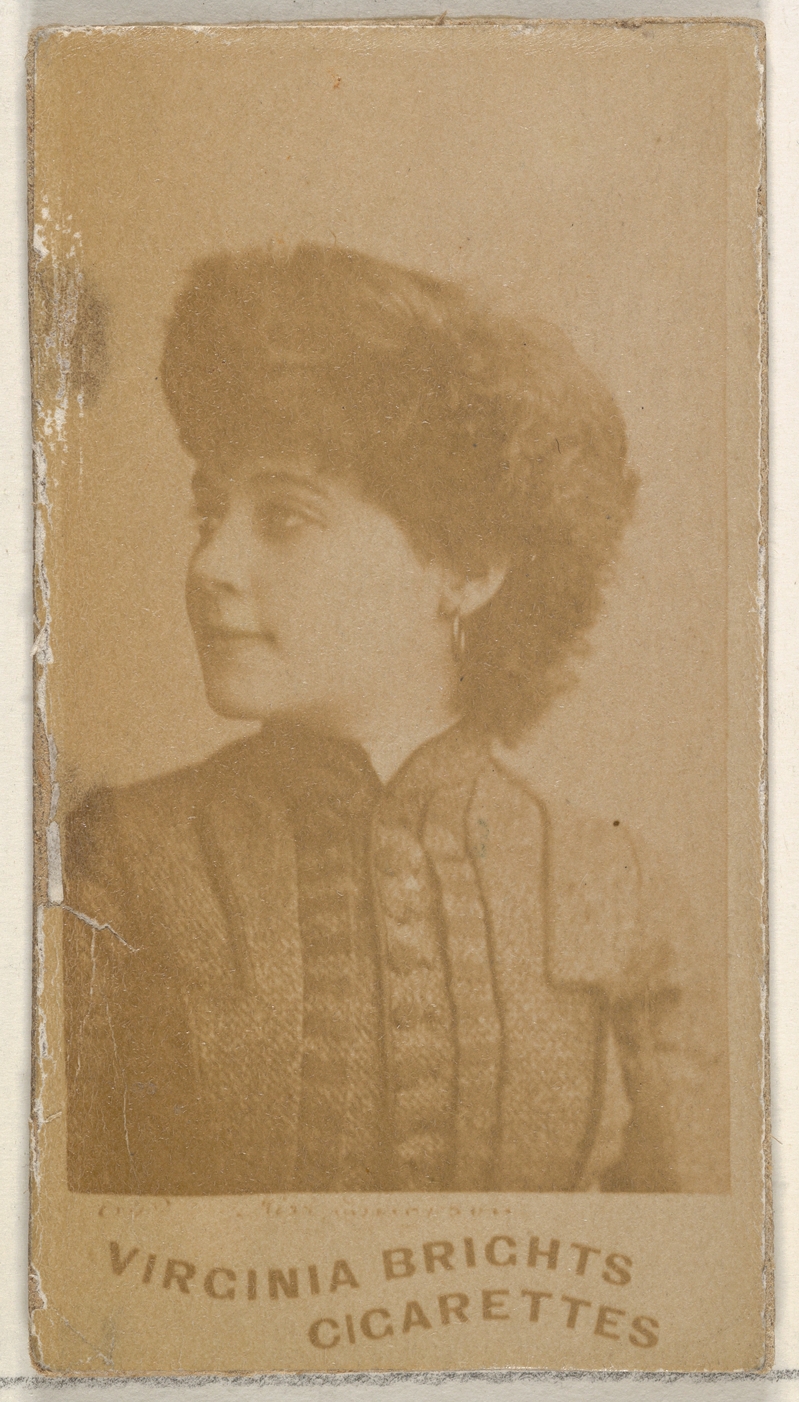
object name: photograph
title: From the Actors and Actresses series (N45, Type 5) for Virginia Brights Cigarettes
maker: allen & ginter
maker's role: publisher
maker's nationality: american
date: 1888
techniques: albumen silver print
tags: portraits,women,actresses